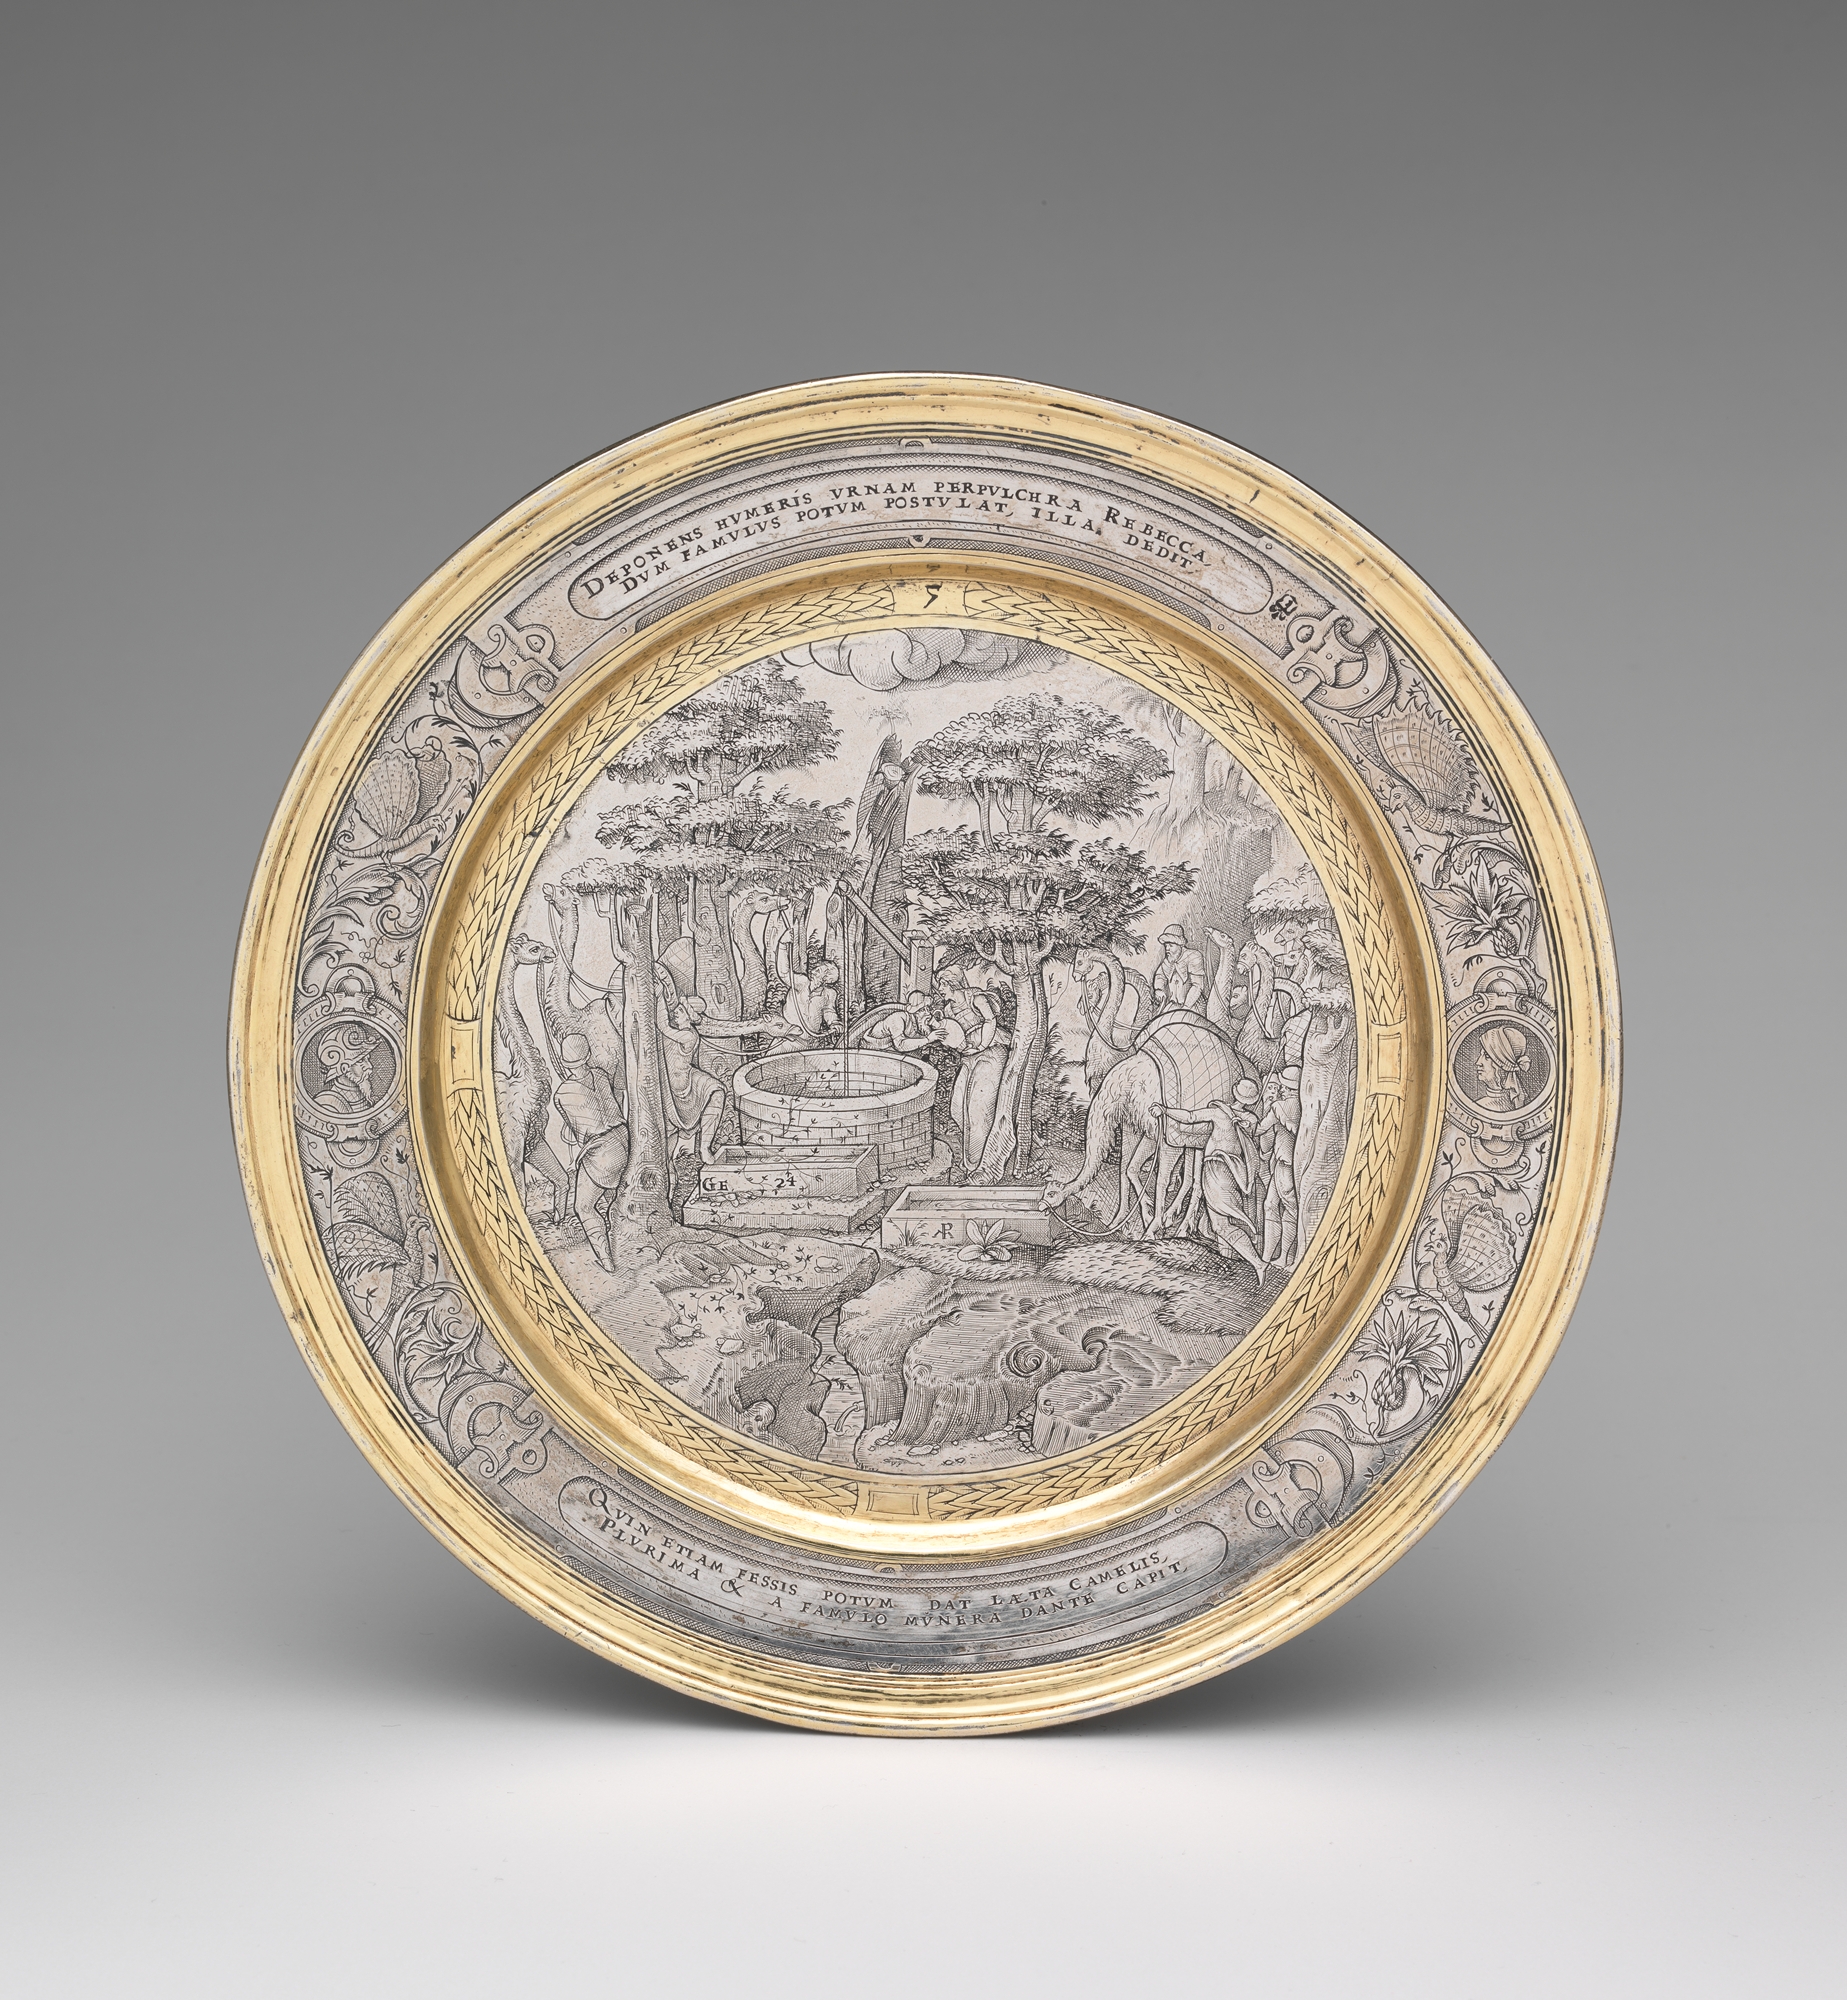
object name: plate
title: Rebecca at the Well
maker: p.m.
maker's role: engraver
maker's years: 1500-1600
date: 1567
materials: silver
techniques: gilding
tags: wells,men,camels,trees